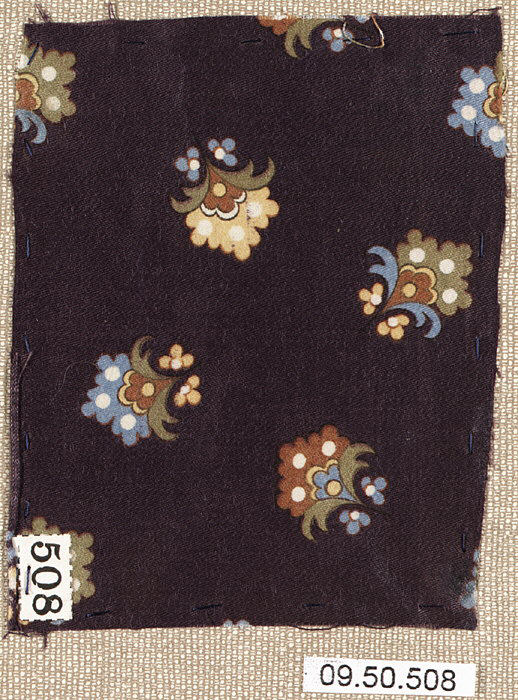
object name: piece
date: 1801-1900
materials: cotton